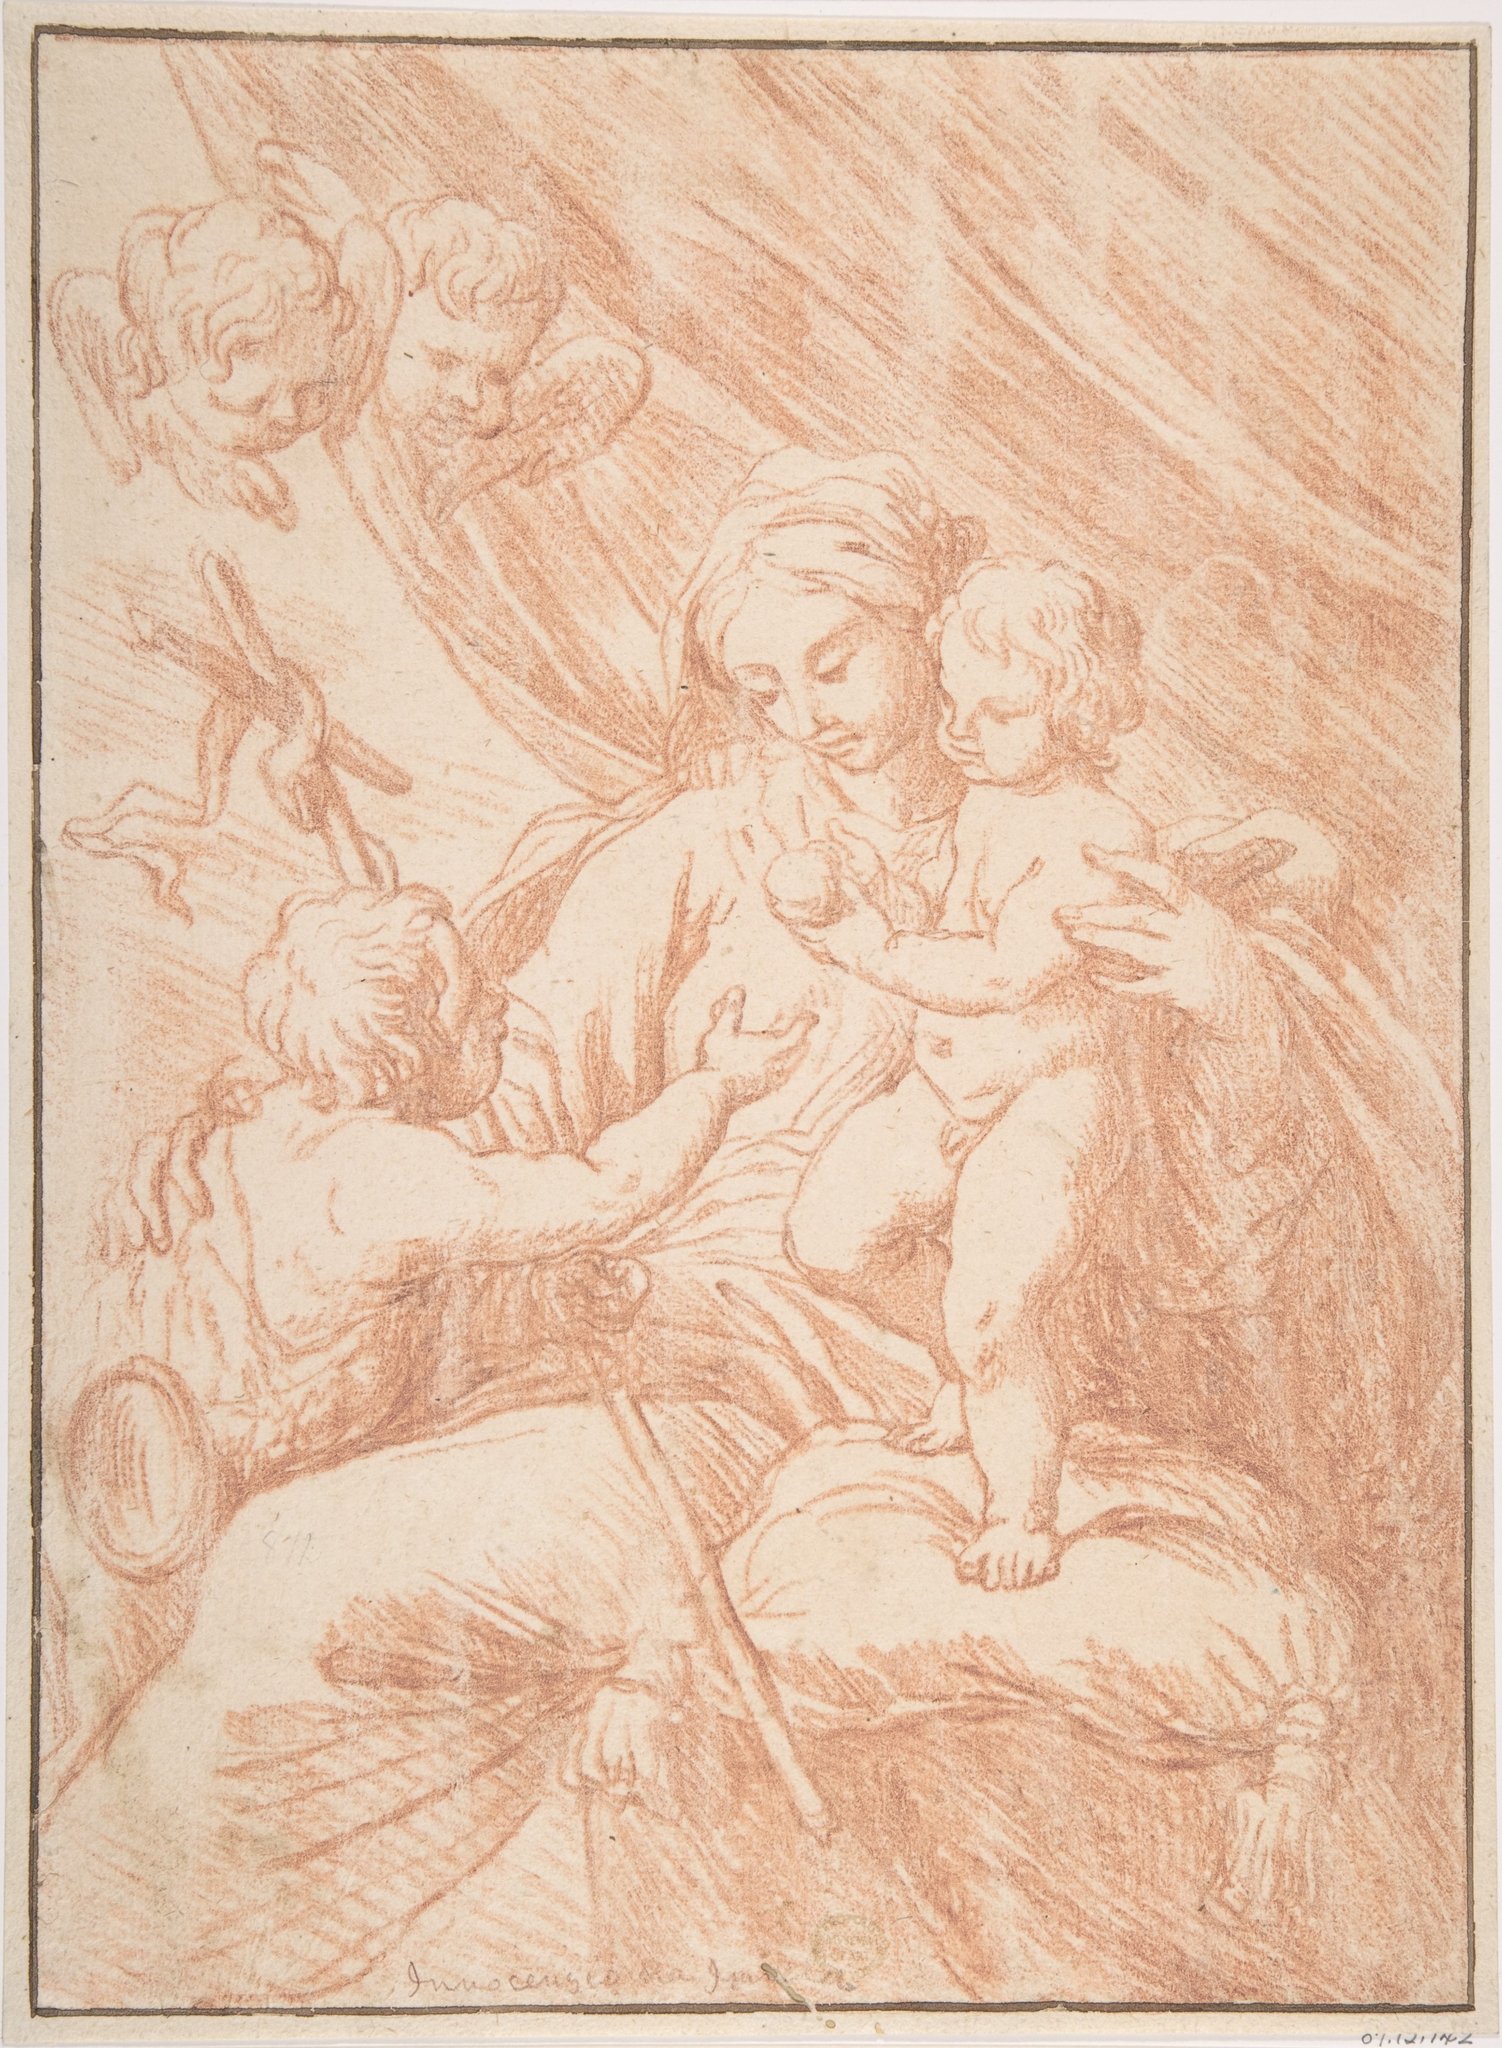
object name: drawing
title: Madonna, Child, and Saint John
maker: anonymous, italian, roman-bolognese, 17th century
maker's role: artist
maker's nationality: italian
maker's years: 1600-1700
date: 1601-1700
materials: chalk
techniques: printmaking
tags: madonna and child,saint john the baptist